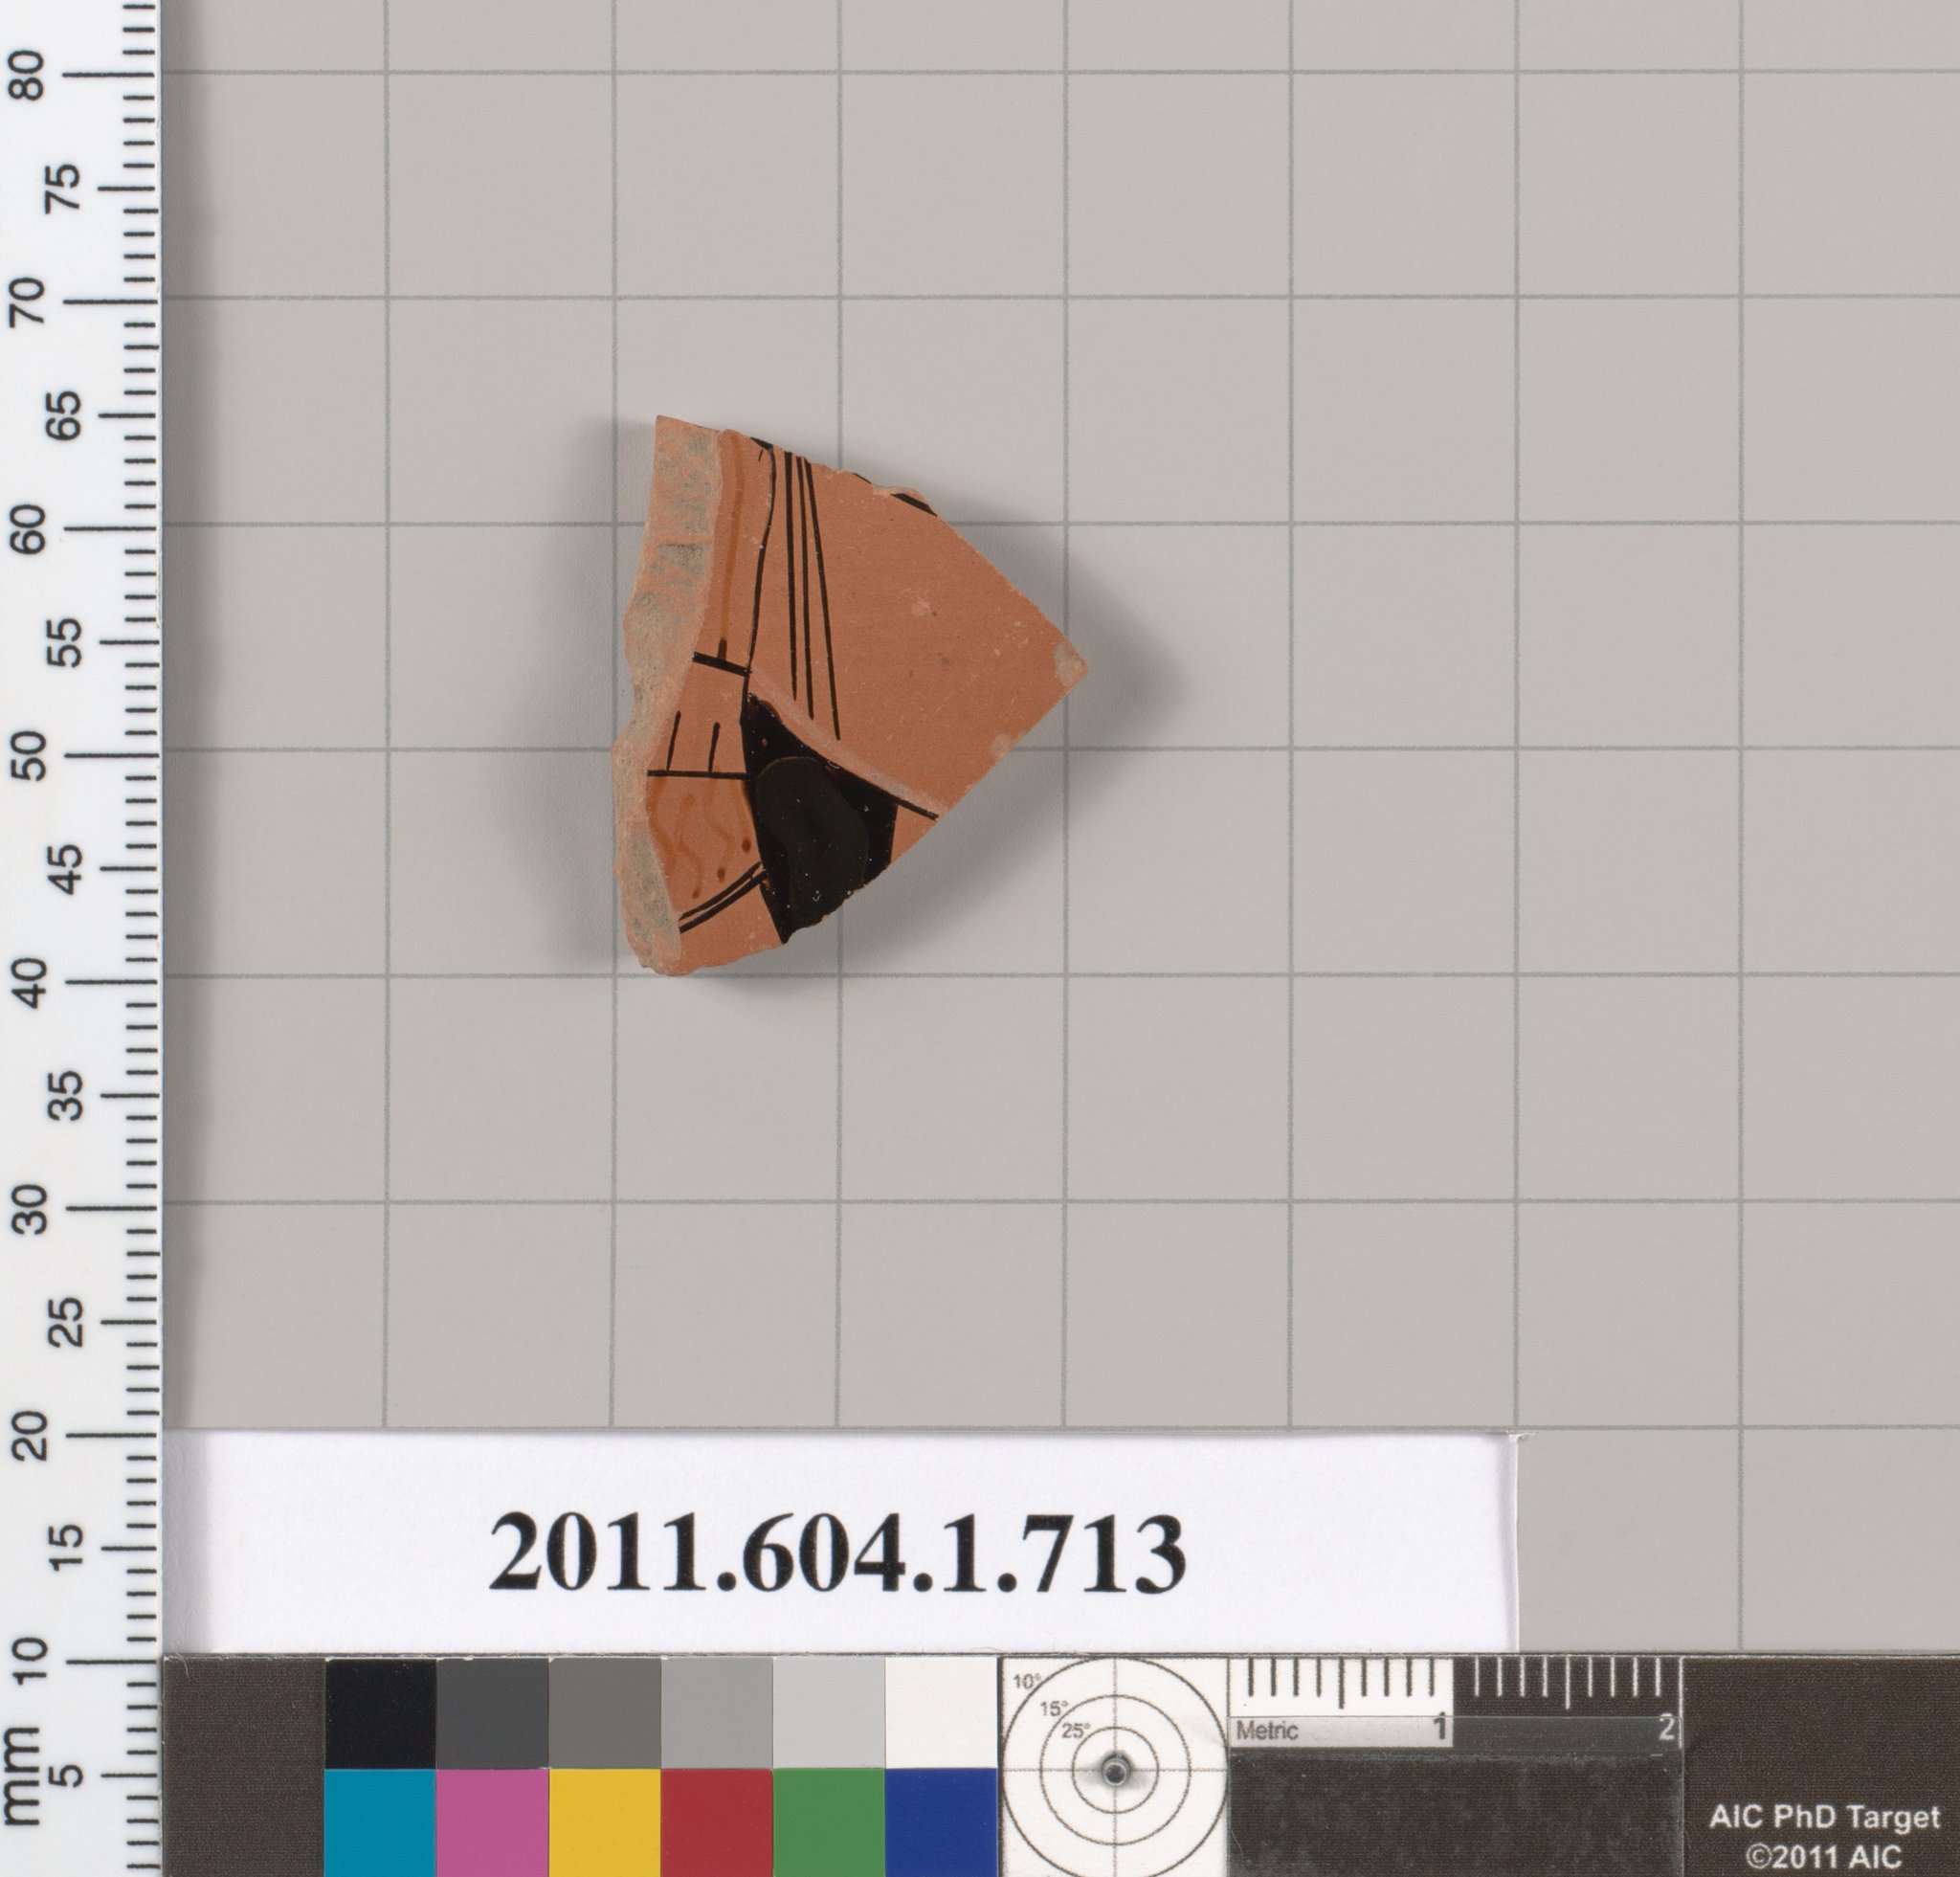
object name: kylix fragment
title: Terracotta fragment of a kylix (drinking cup)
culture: greek, attic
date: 500-476 BCE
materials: terracotta